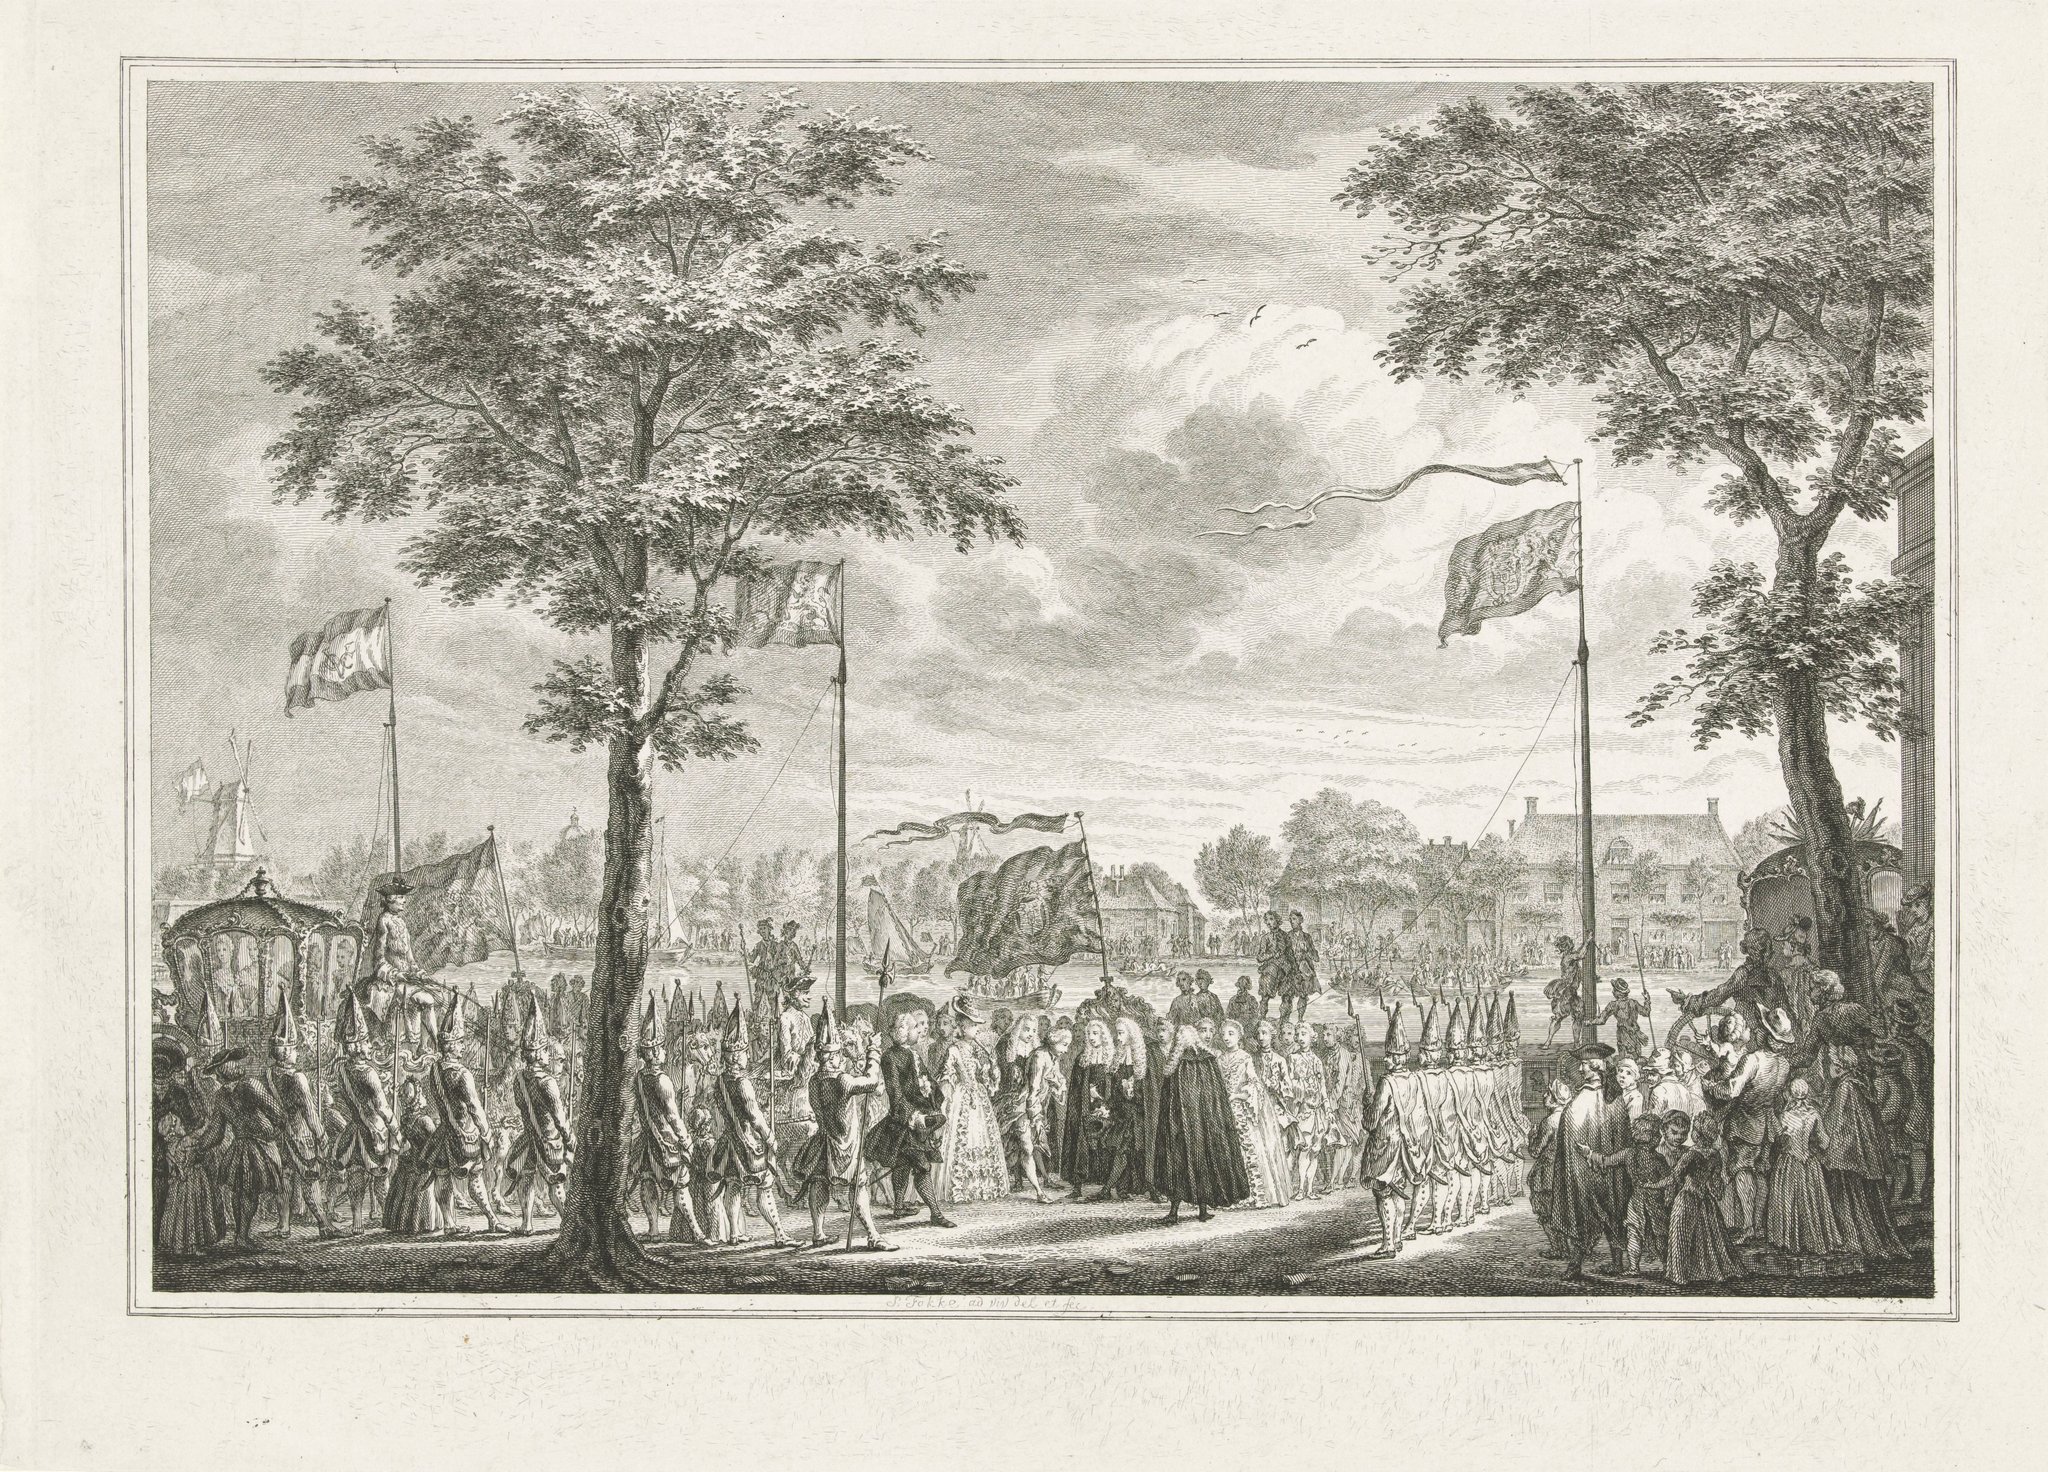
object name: print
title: Afbeelding der Vreugdebedryven en Plegtigheden die by de aankomst en gedurende het verblyf (...) Willem (...) en zyne Gemaalinne (...) zyn voorgevallen te Amsterdam, op maandag, den 30 Mey, en eenige volgende dagen, des jaars 1768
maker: simon fokke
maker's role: draughtsman, print maker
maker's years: 1712-1784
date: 1769-1773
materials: paper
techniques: engraving, etching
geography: northern netherlands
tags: william v (prince of orange), berlin, painter, draughtsman, wilhelmina of prussia (princess of orange), public festivities on the occasion of royal events, amsterdam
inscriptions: collector's mark: Lugt 2228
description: De stadhouder Willem V en prinses Wilhelmina van Pruisen nemen afscheid van het magistraat van Amsterdam bij de herberg De Berebijt aan de Buitenamstel, 4 juni 1768. Onderdeel van een prentserie met titelprent en 14 platen van de inhaling van de prins en prinses te Amsterdam, 30 mei - 4 juni 1768.